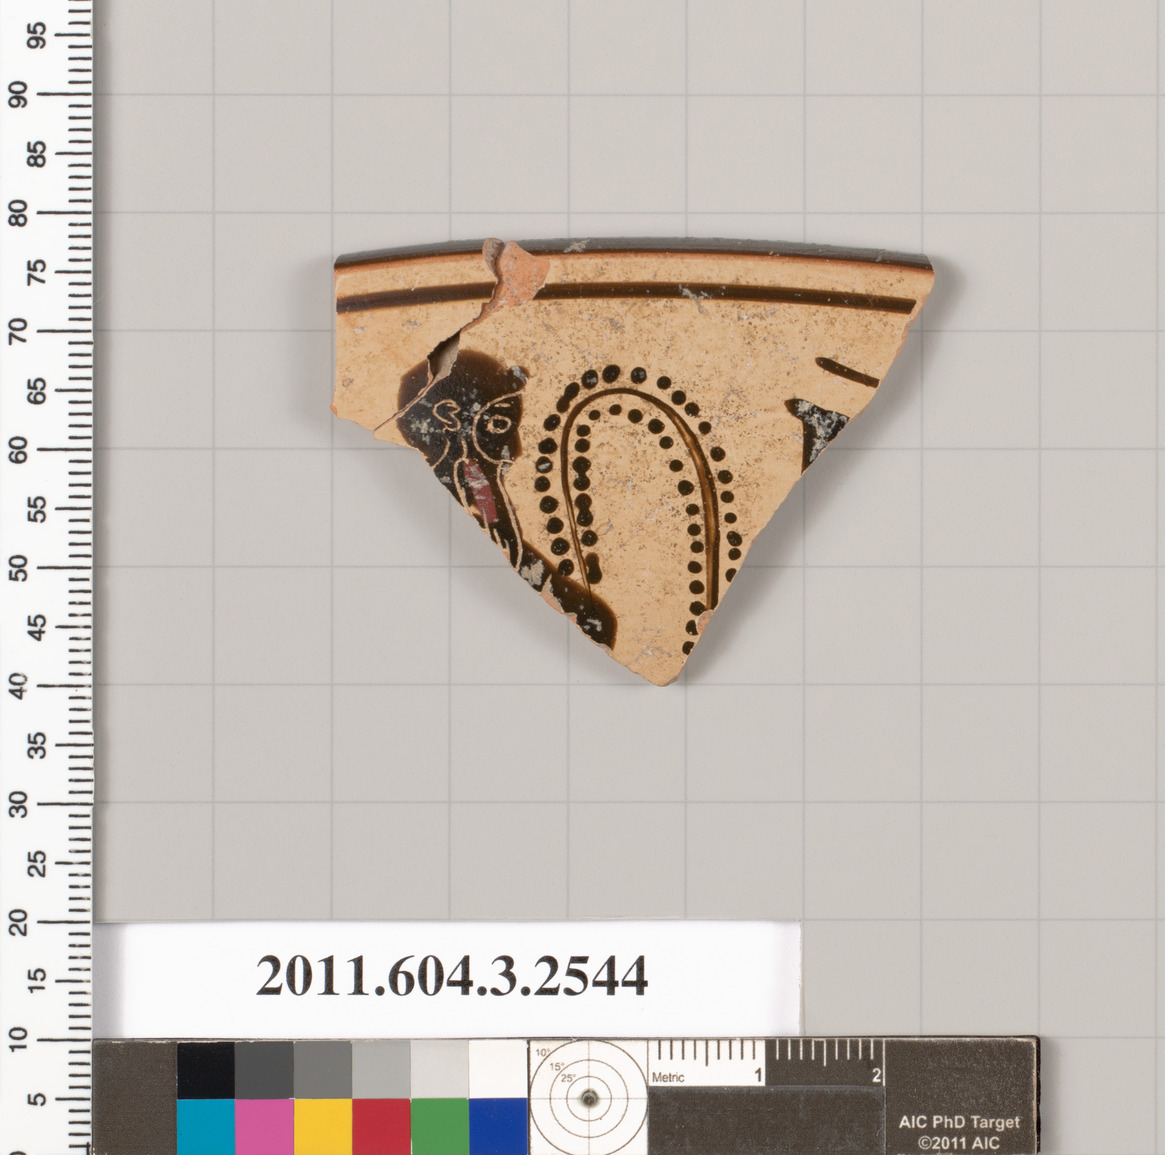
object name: kylix fragment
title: Terracotta rim fragment of a kylix: eye-cup (drinking cup)?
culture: greek, attic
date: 534-468 BCE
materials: terracotta